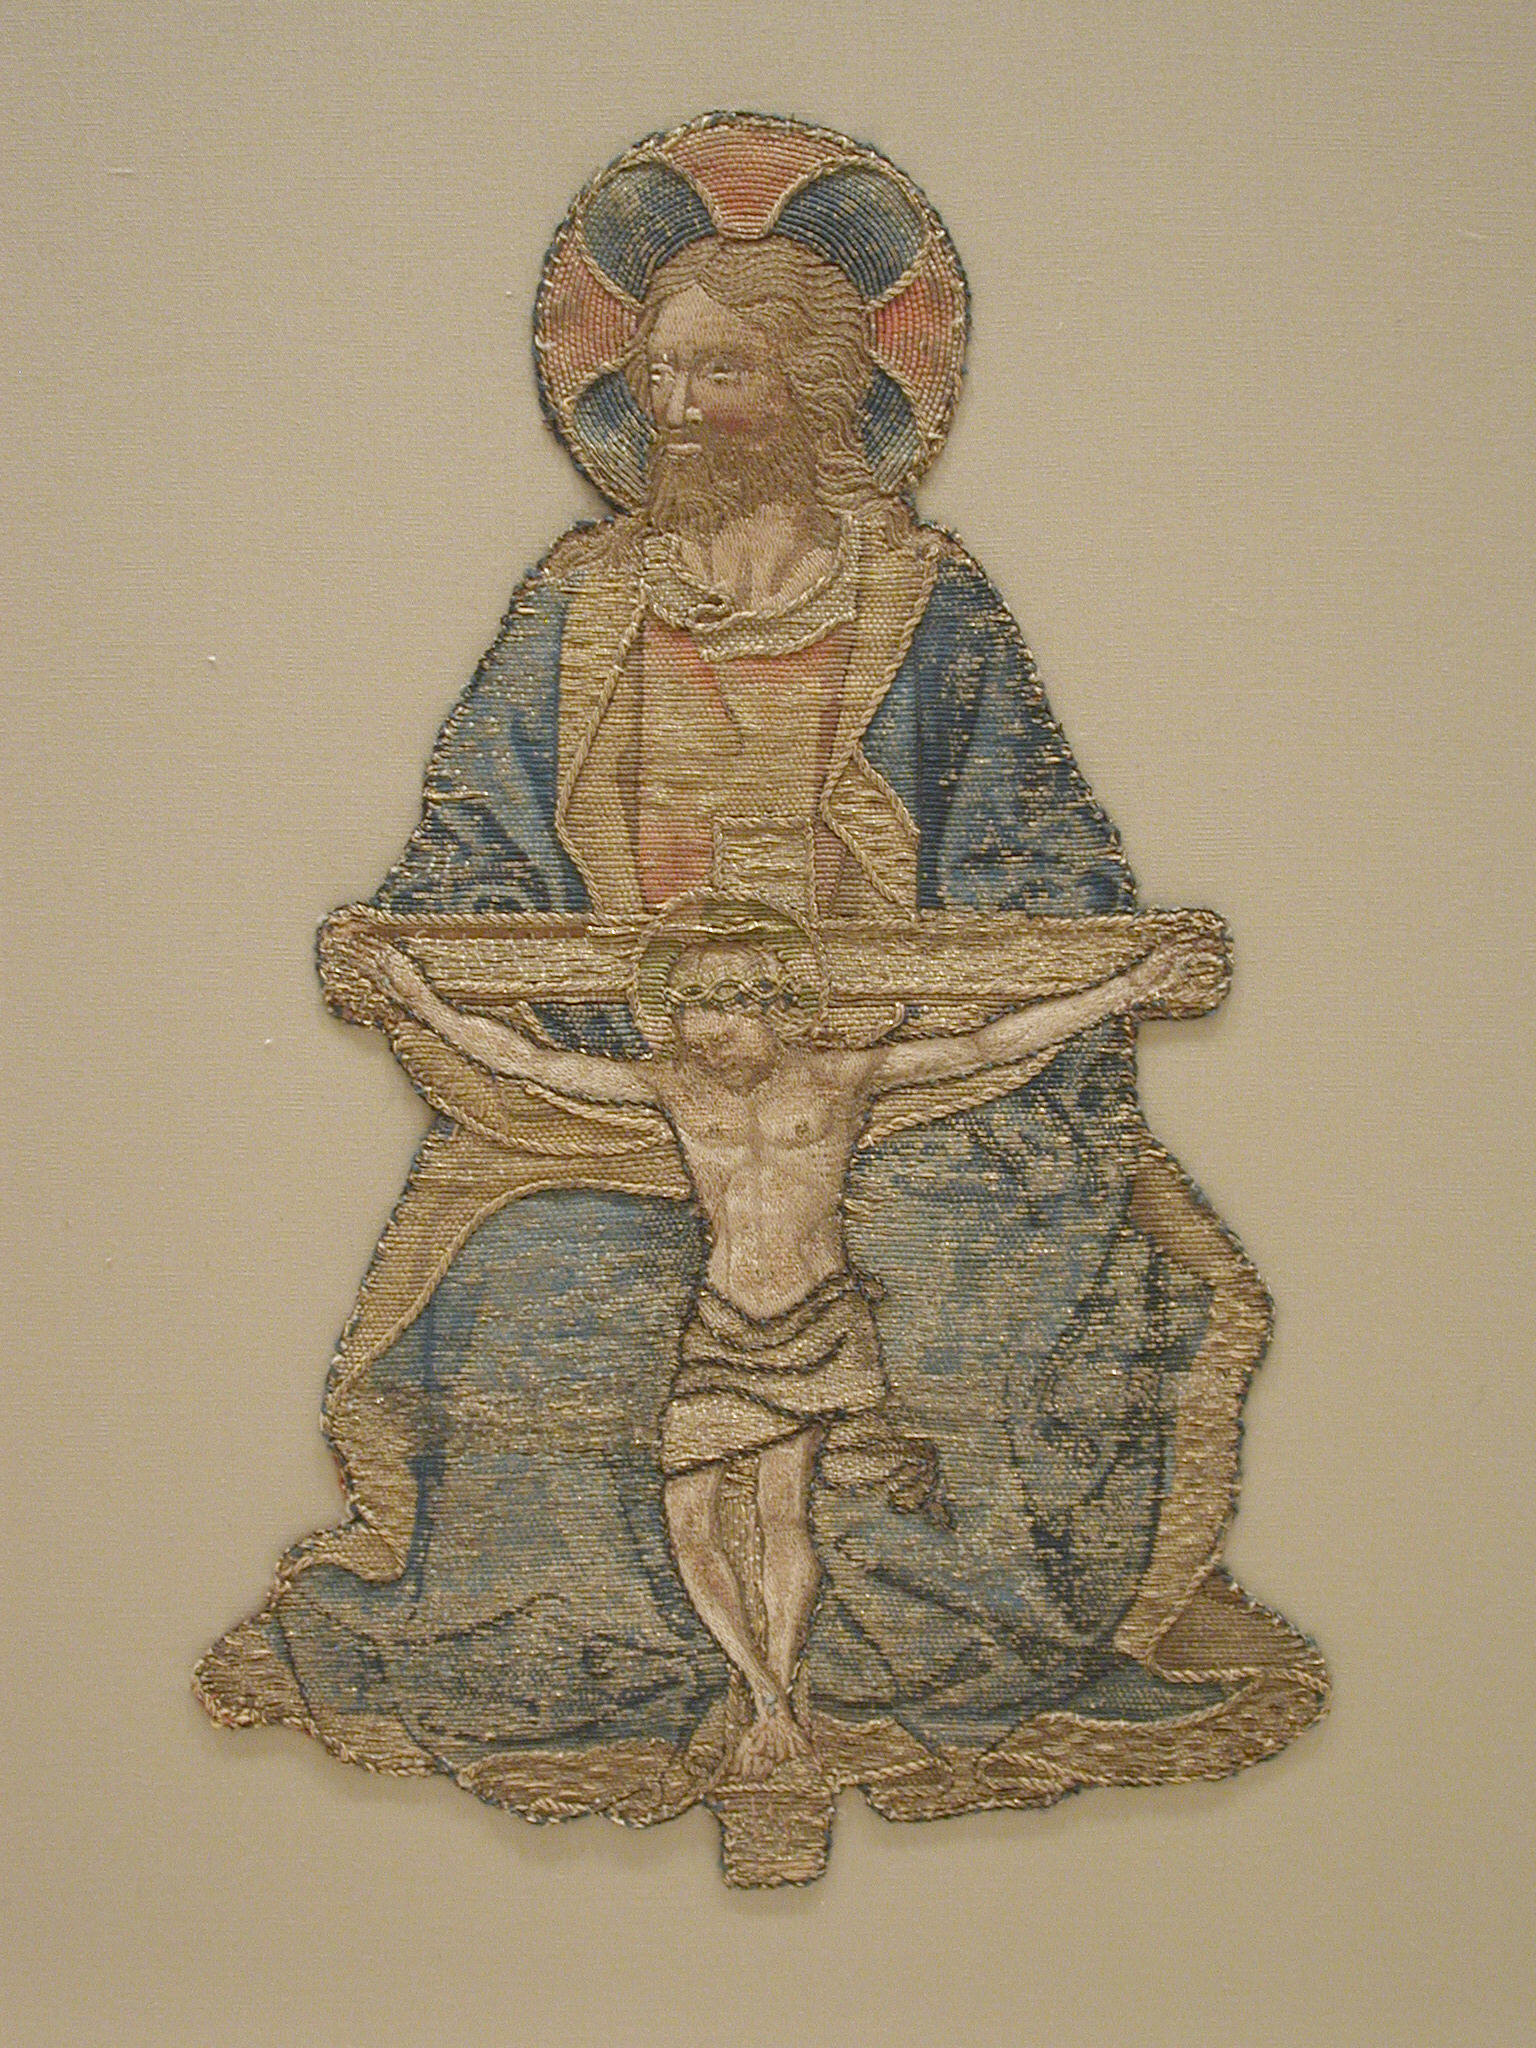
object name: panel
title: The Throne of Grace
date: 1434-1466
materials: metal thread, silk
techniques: embroidery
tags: christ,crucifixion